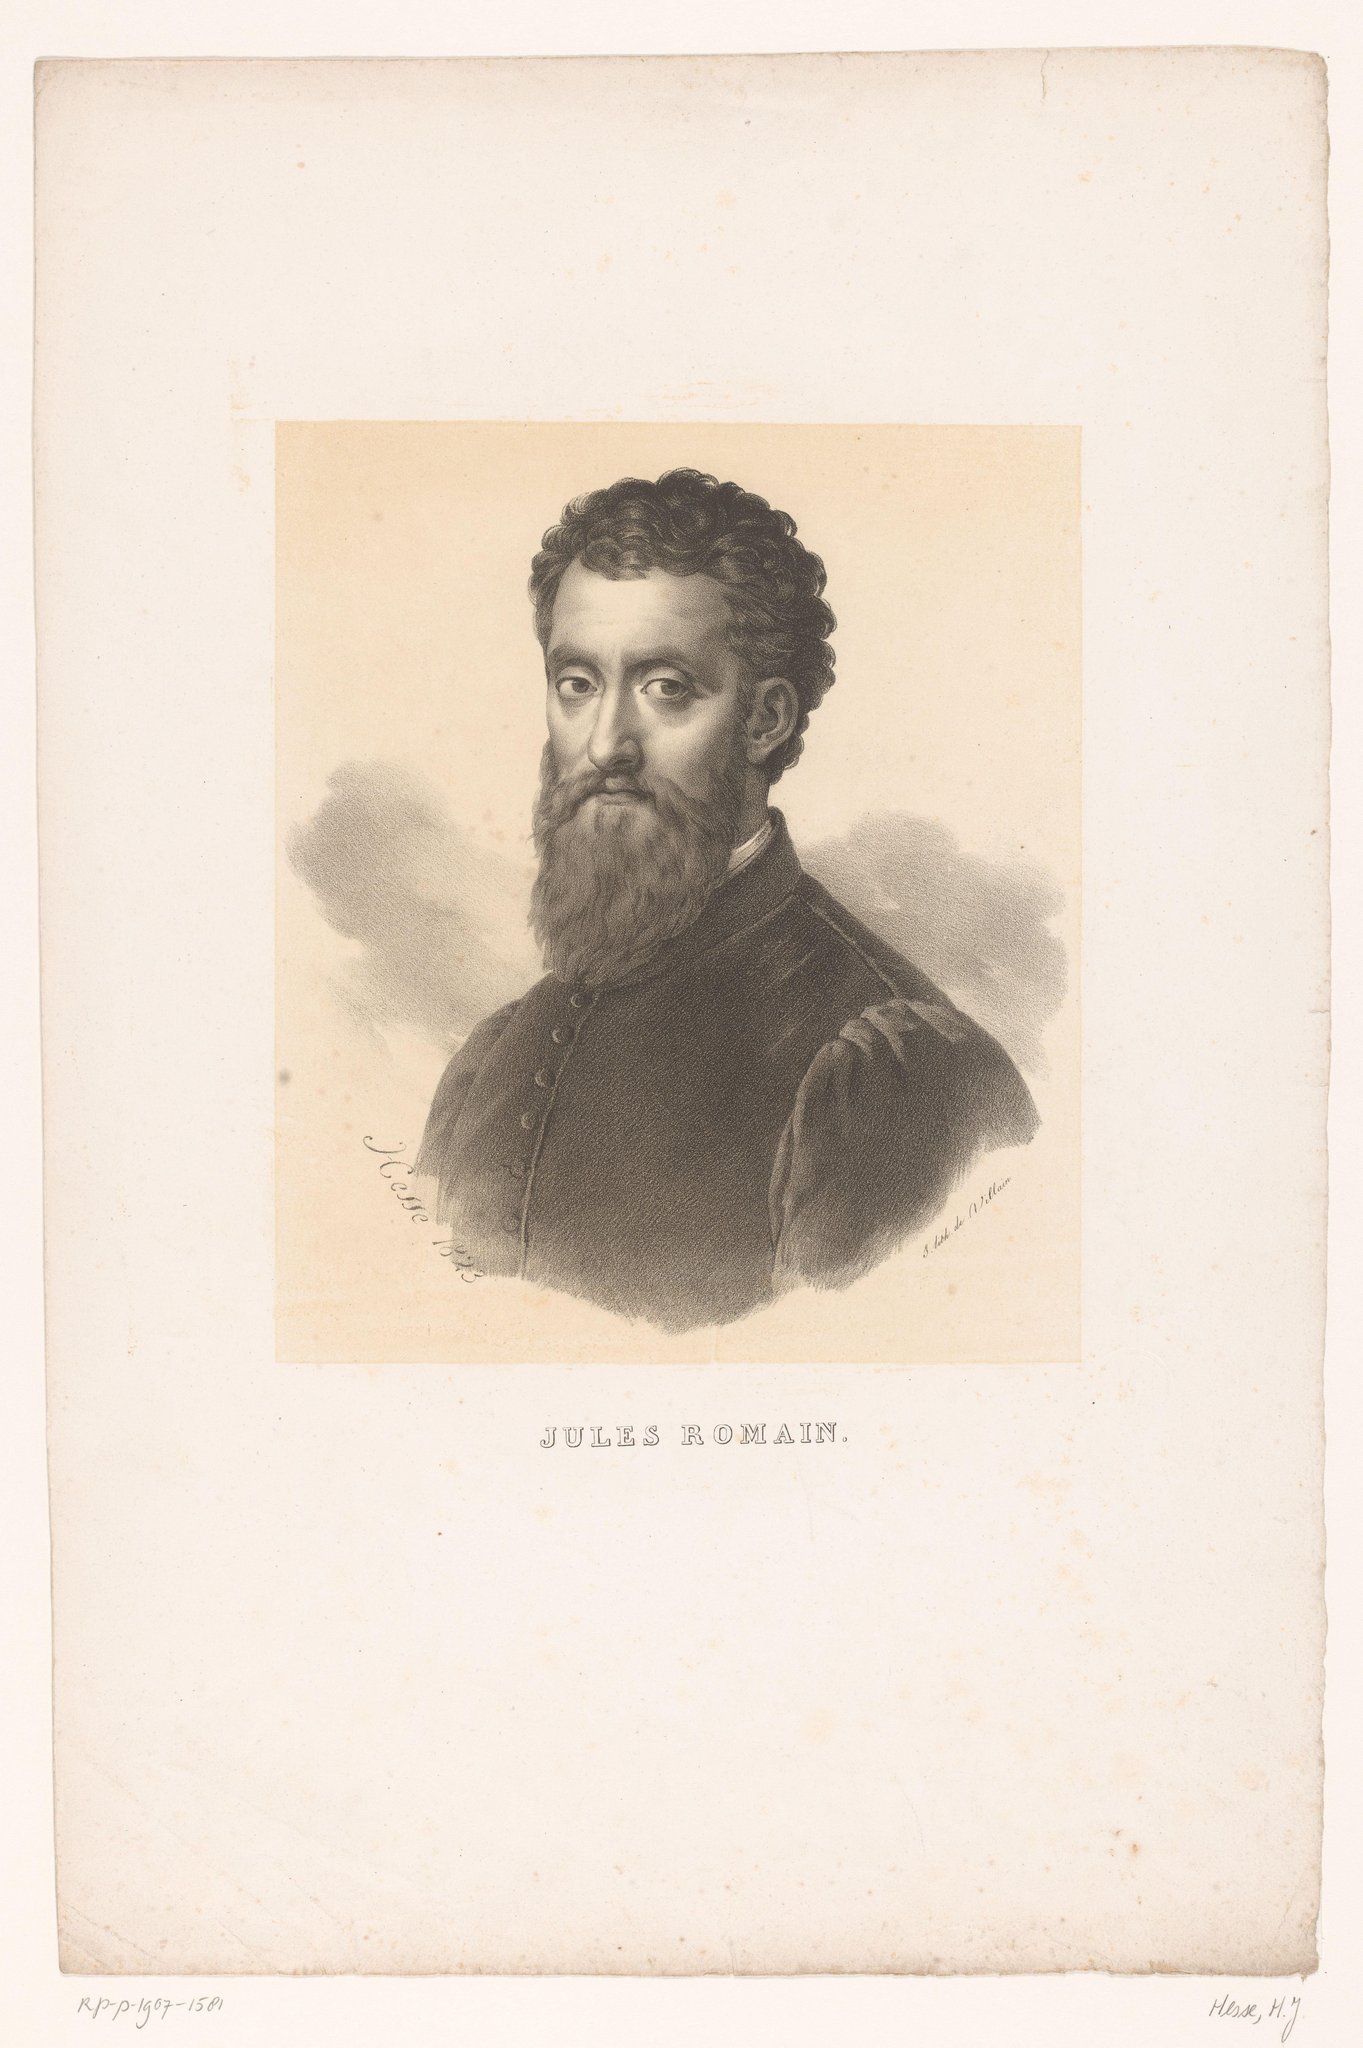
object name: print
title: Portret van Giulio Romano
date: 1823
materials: paper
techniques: lithograph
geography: paris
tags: painter, print maker, draughtsman, giulio romano, historical persons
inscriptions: collector's mark: Lugt 2228a, check stamp: ‘JC (?)’